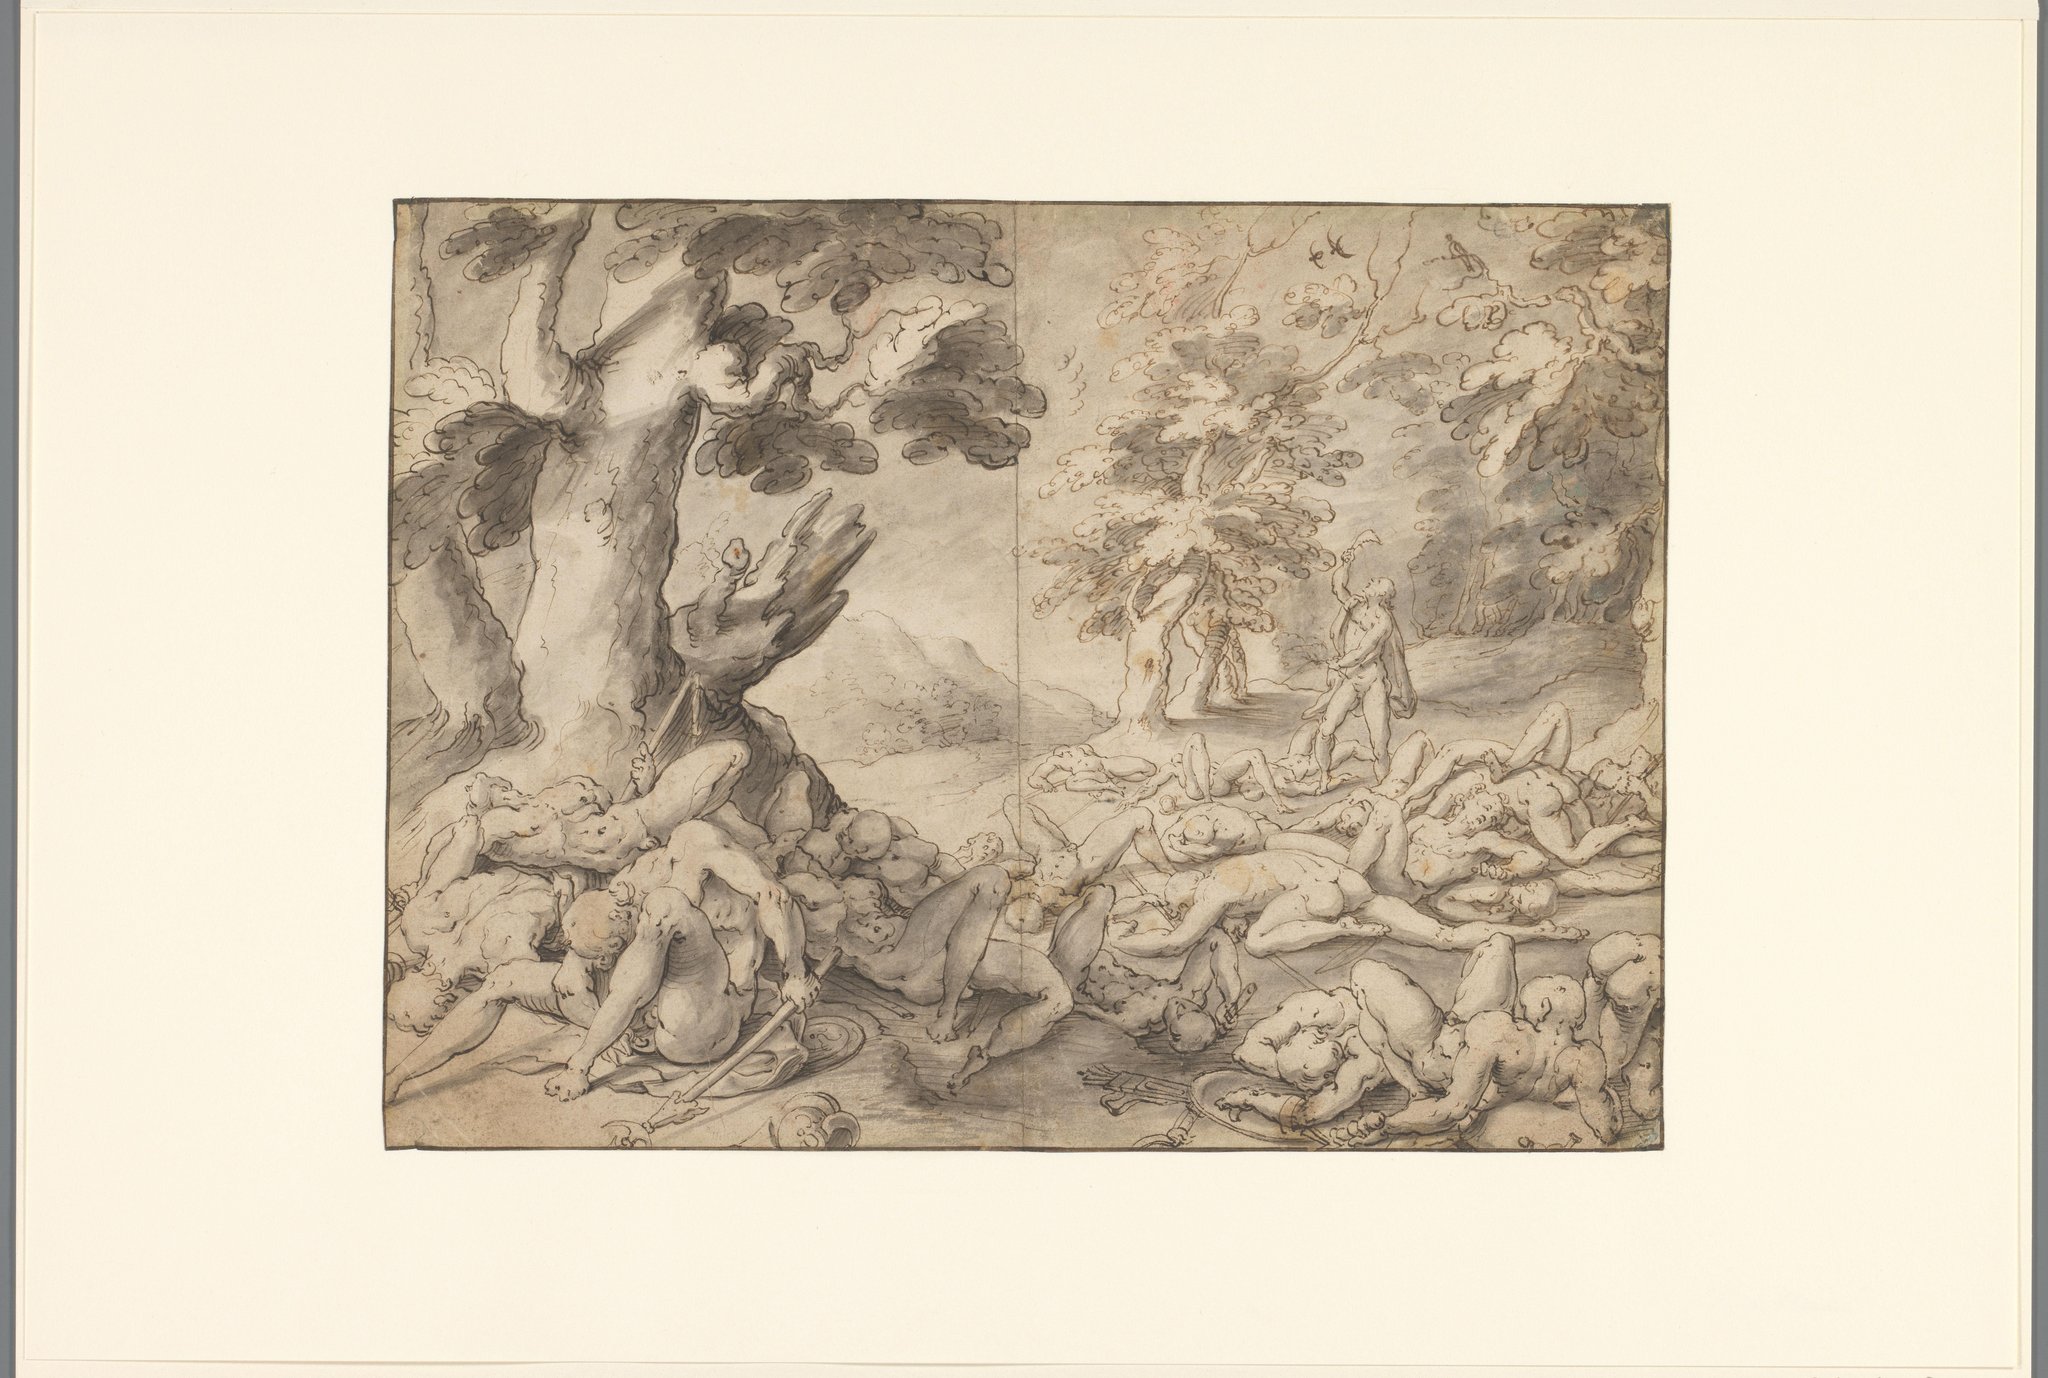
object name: drawing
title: Samson na het verslaan van de Filistijnen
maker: gerrit pietersz. sweelink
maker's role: draughtsman, painter, print maker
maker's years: 1566-1612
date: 1576-1656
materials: ink, paper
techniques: brush, pen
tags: with an ass's jaw-bone samson slays a thousand philistines